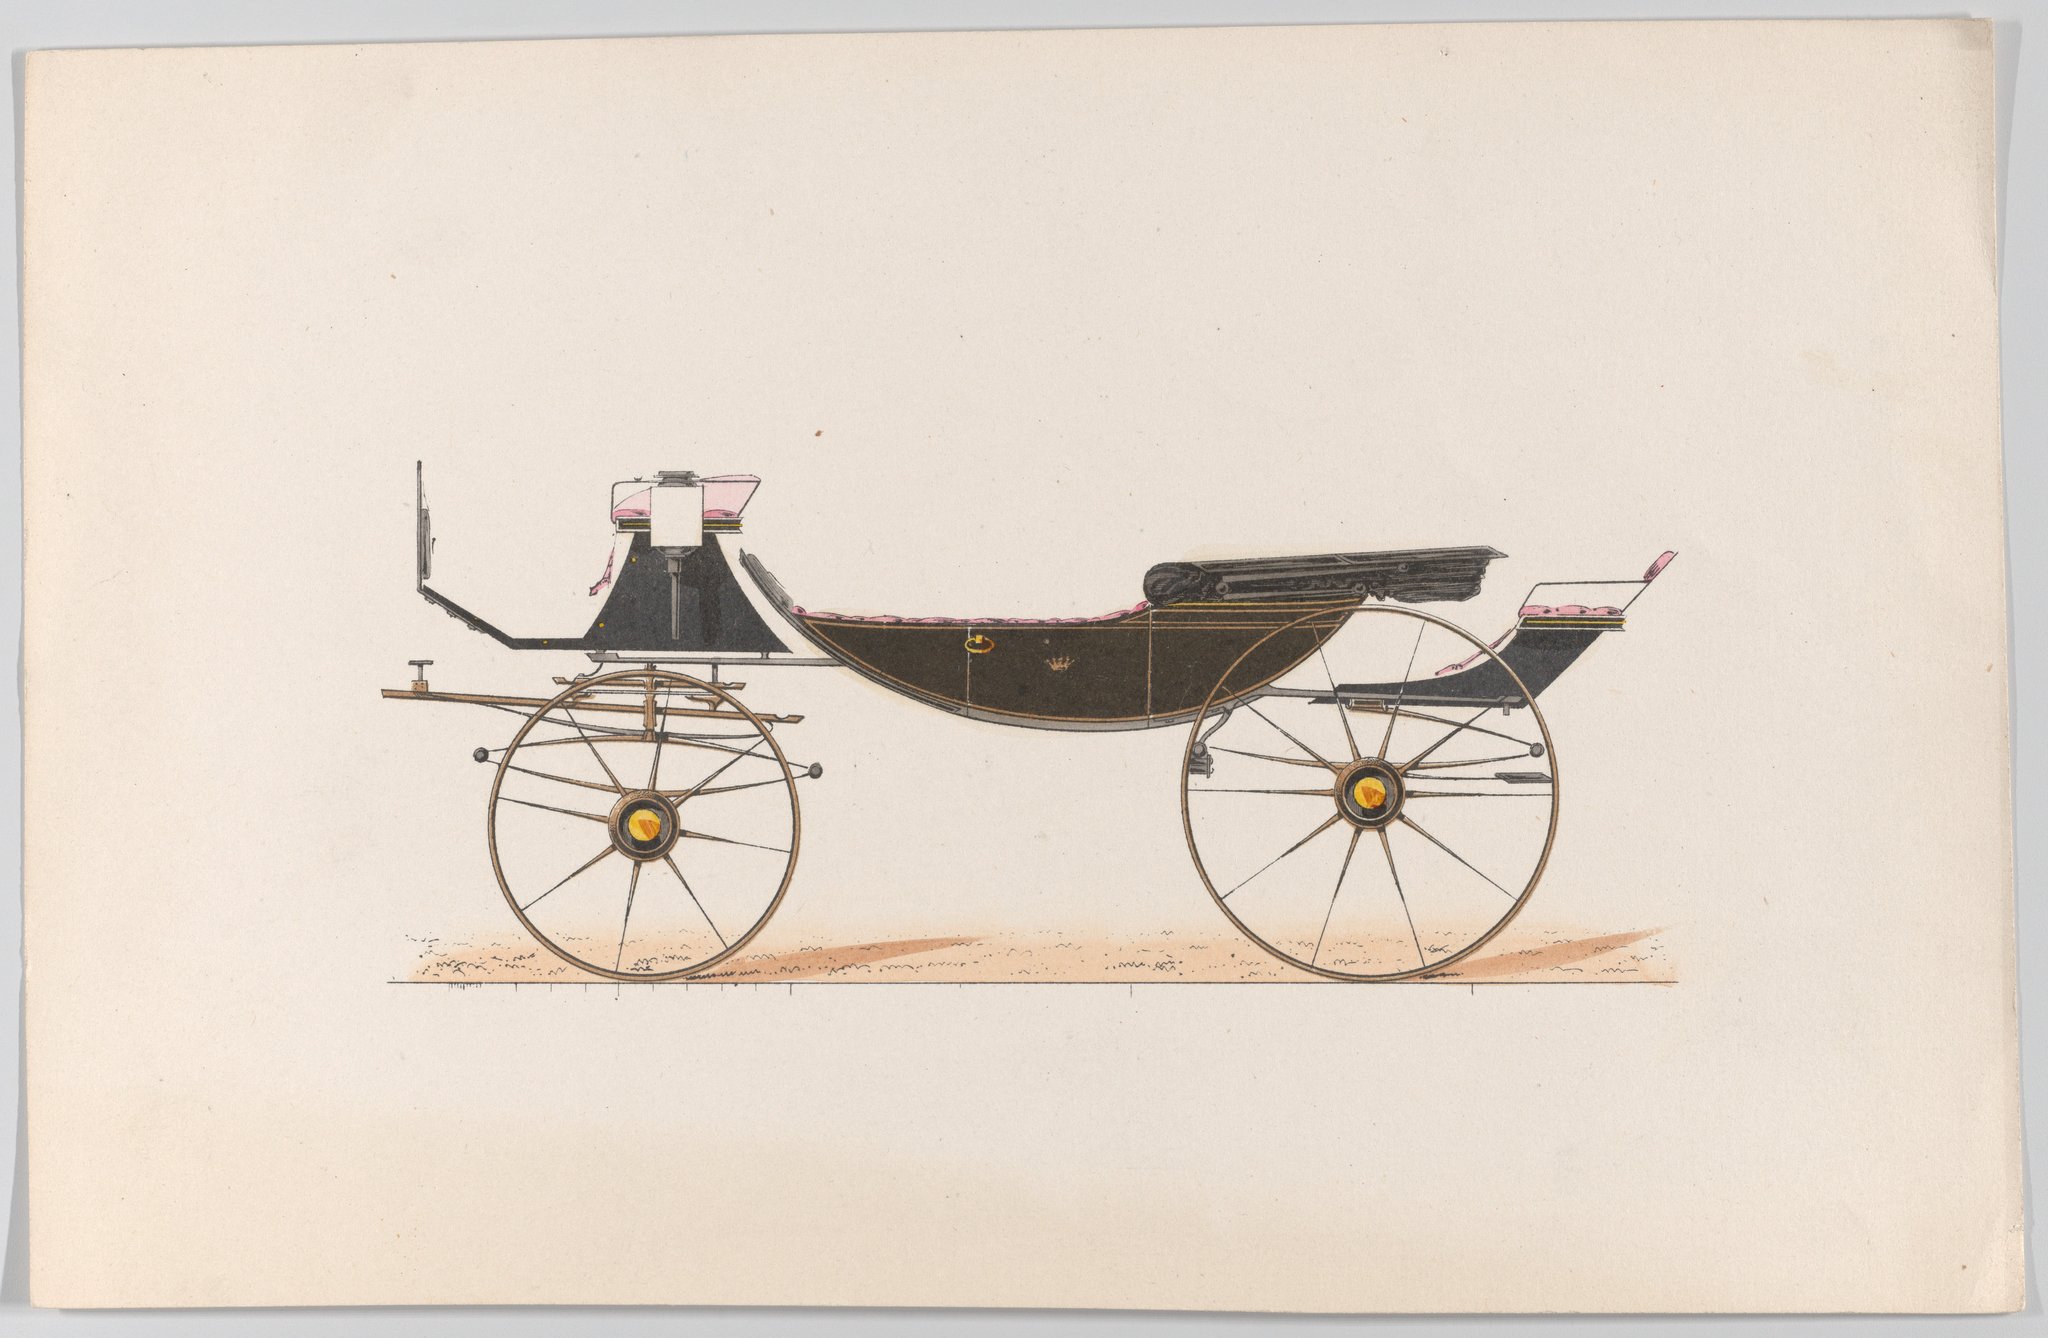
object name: drawing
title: Design for Vis-à-vis "Sociable" (unnumbered)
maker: brewster & co.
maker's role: manufacturer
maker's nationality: american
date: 1870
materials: gum arabic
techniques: hand coloring, lithograph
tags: carriages